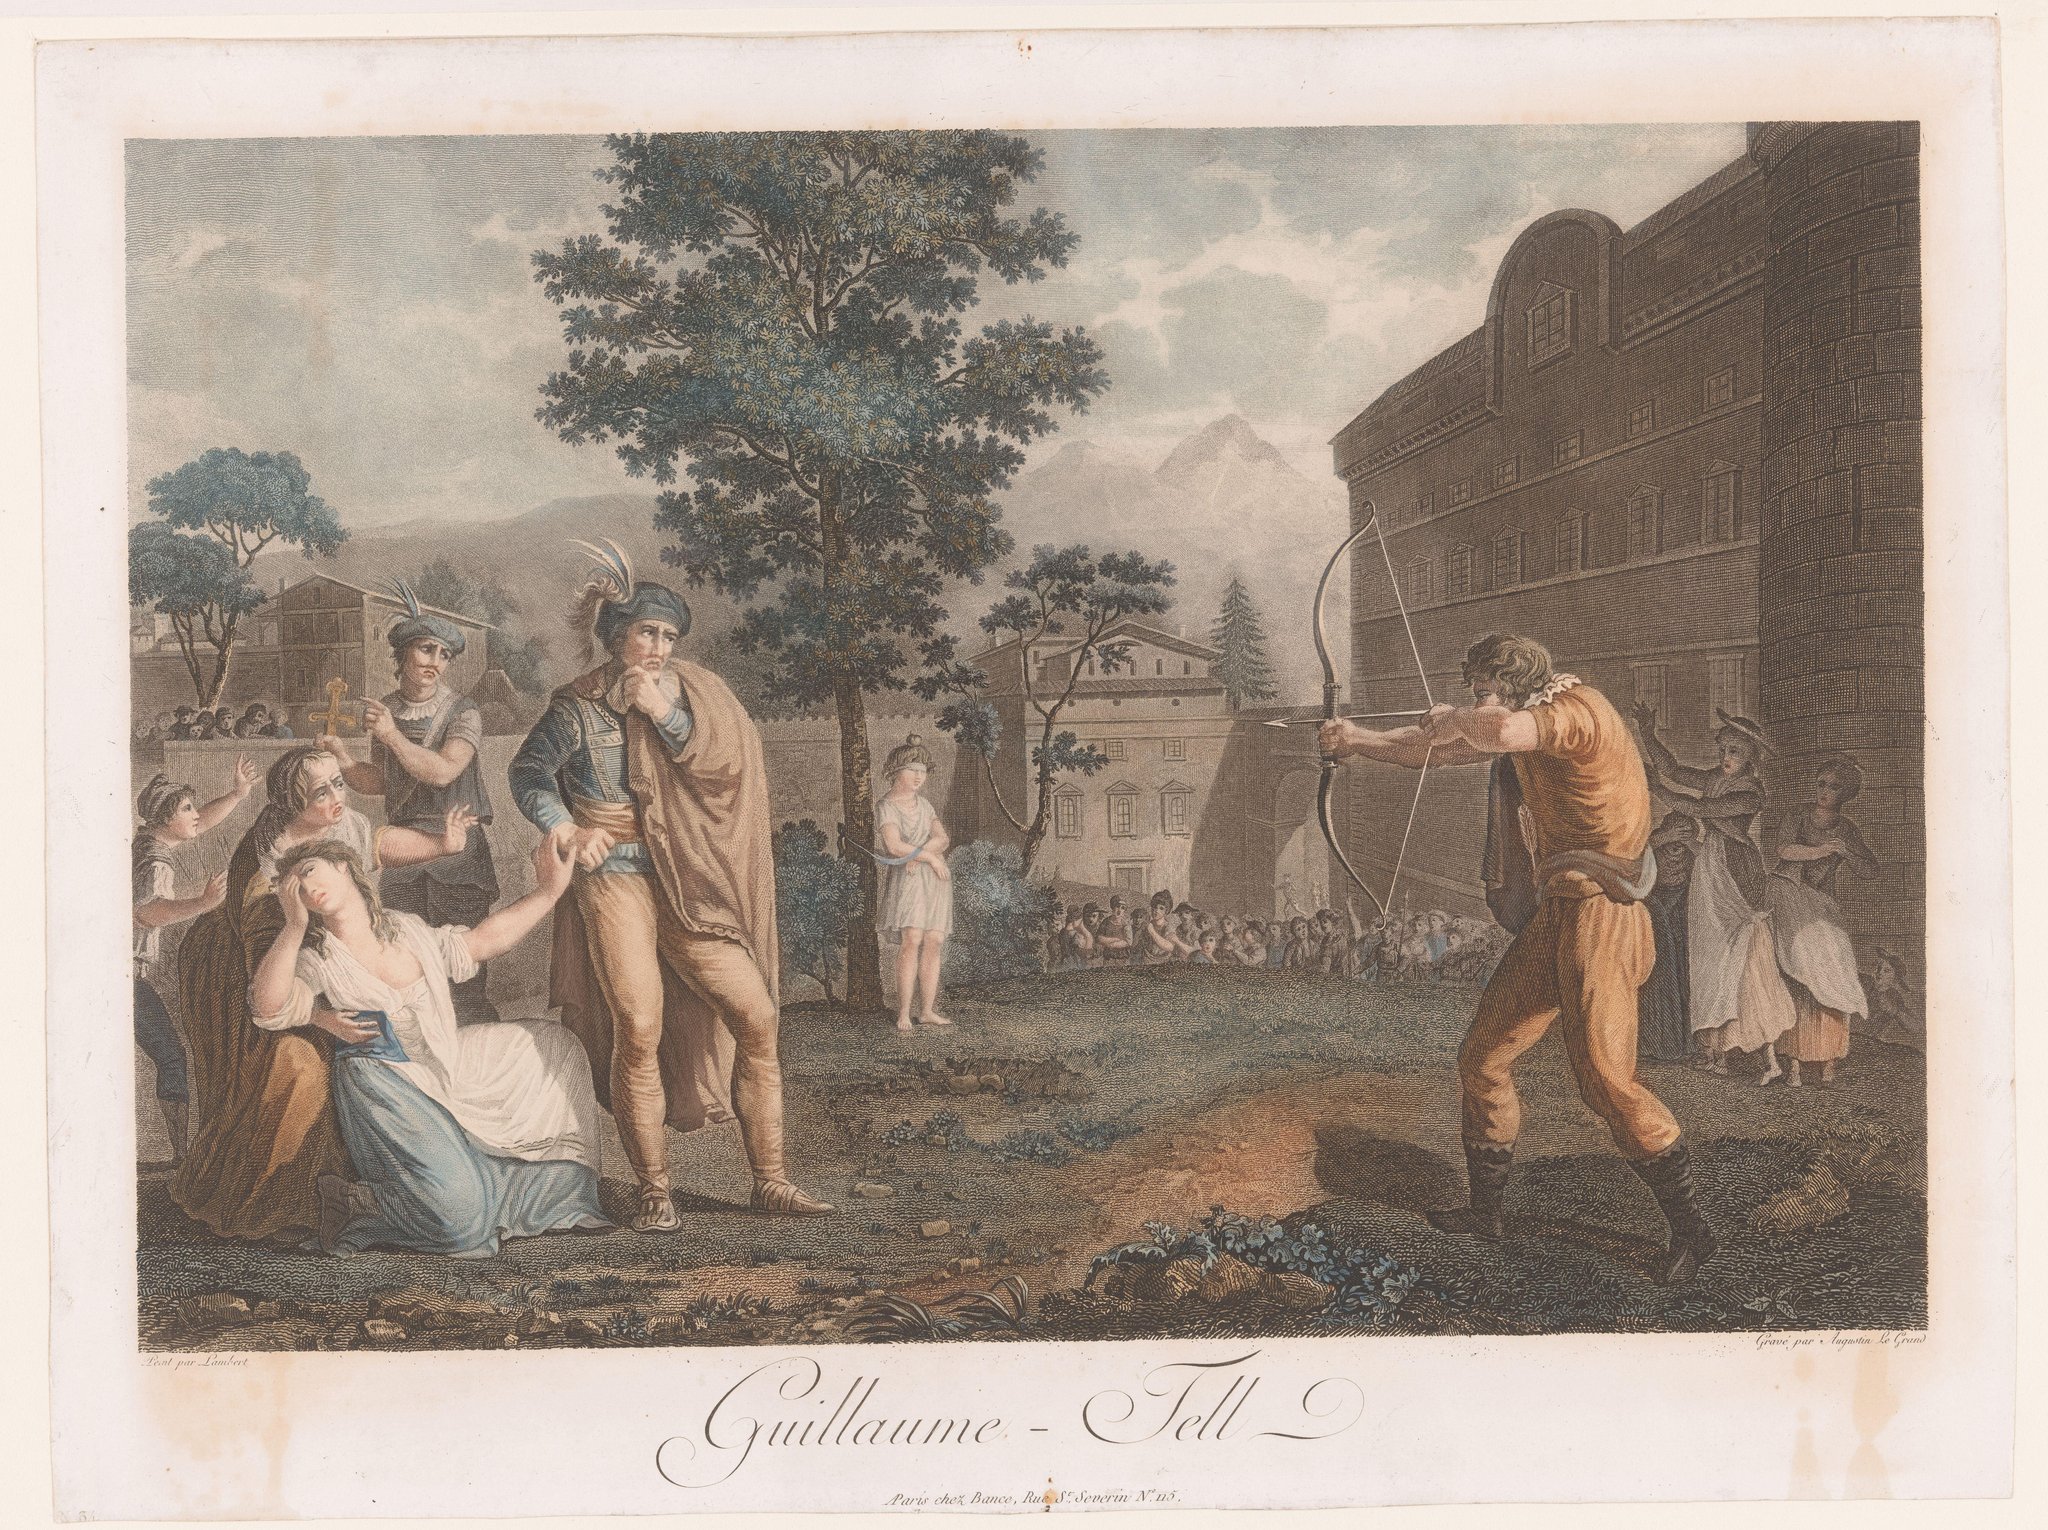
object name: print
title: Guillaume-Tell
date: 1775-1815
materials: paper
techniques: engraving, etching, hand coloring, lithography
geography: france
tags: archer's weapons: bow and arrow, fruits: apple, historical persons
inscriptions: collector's mark: Lugt 2228